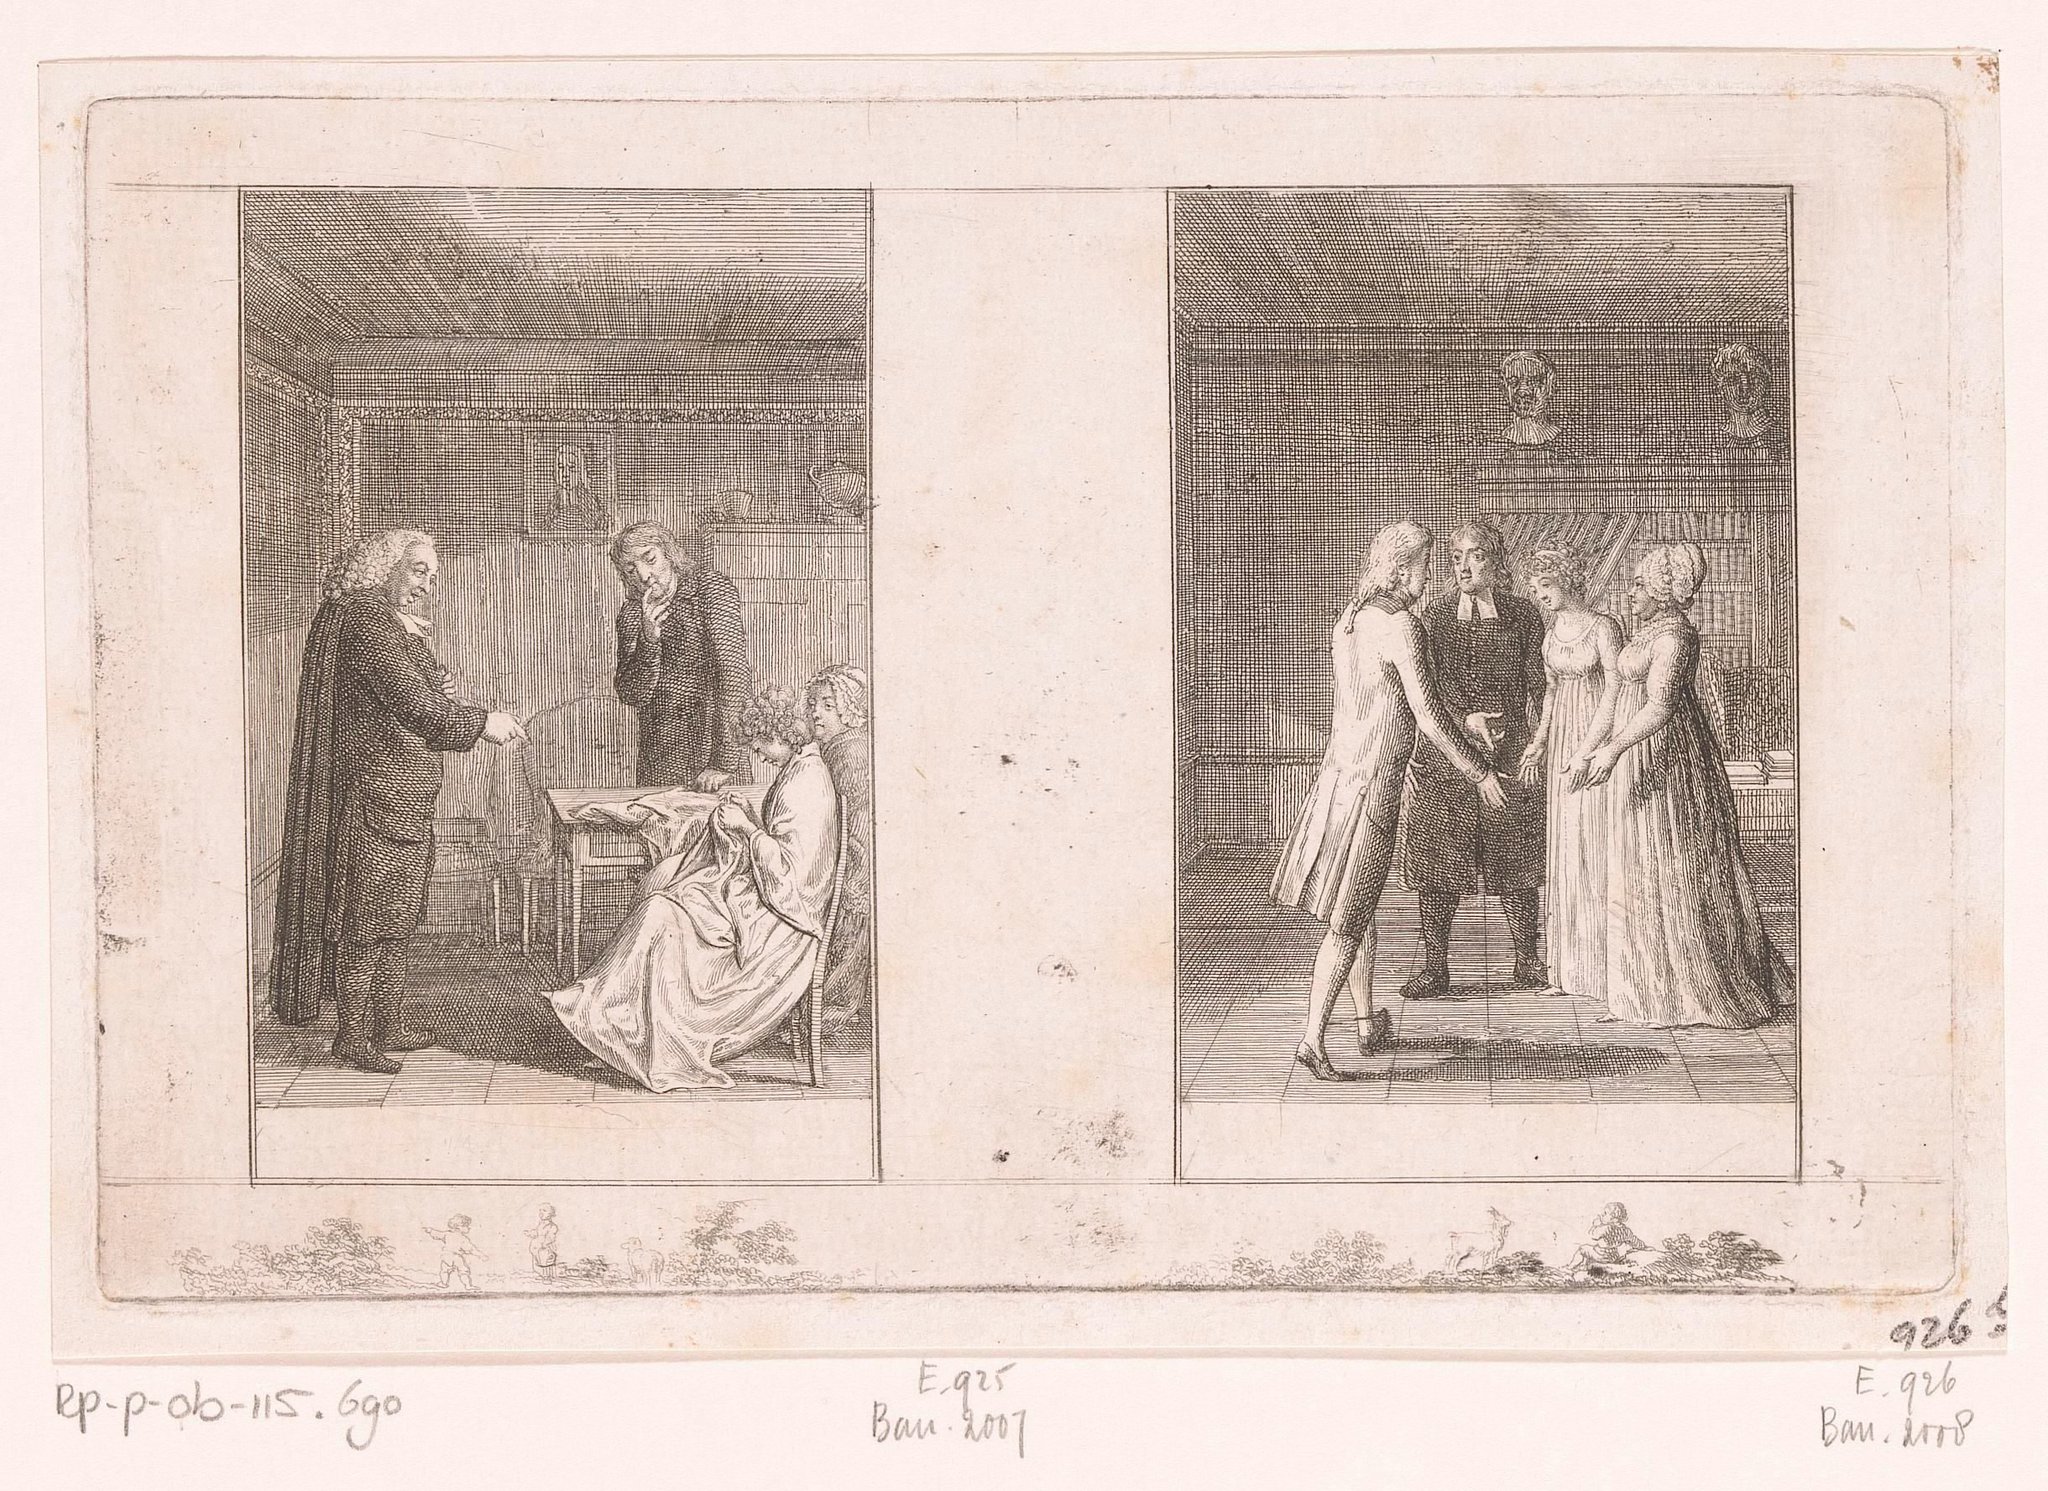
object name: print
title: Twee voorstellingen uit de verhalen van Wilhelm Gottlieb Becker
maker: daniel nikolaus chodowiecki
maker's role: draughtsman, print maker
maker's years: 1726-1801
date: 1800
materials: paper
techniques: etching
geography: berlin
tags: piece of sculpture, reproduction of a piece of sculpture, quarrel, argument, sewing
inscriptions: collector's mark: Lugt 2228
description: Prenten gebruikt voor: Becker, Wilhelm Gottlieb. W. G. Becker's Taschenbuch zum geselligen Vergnügen. Leipzig: Roch und Comp, 1801.